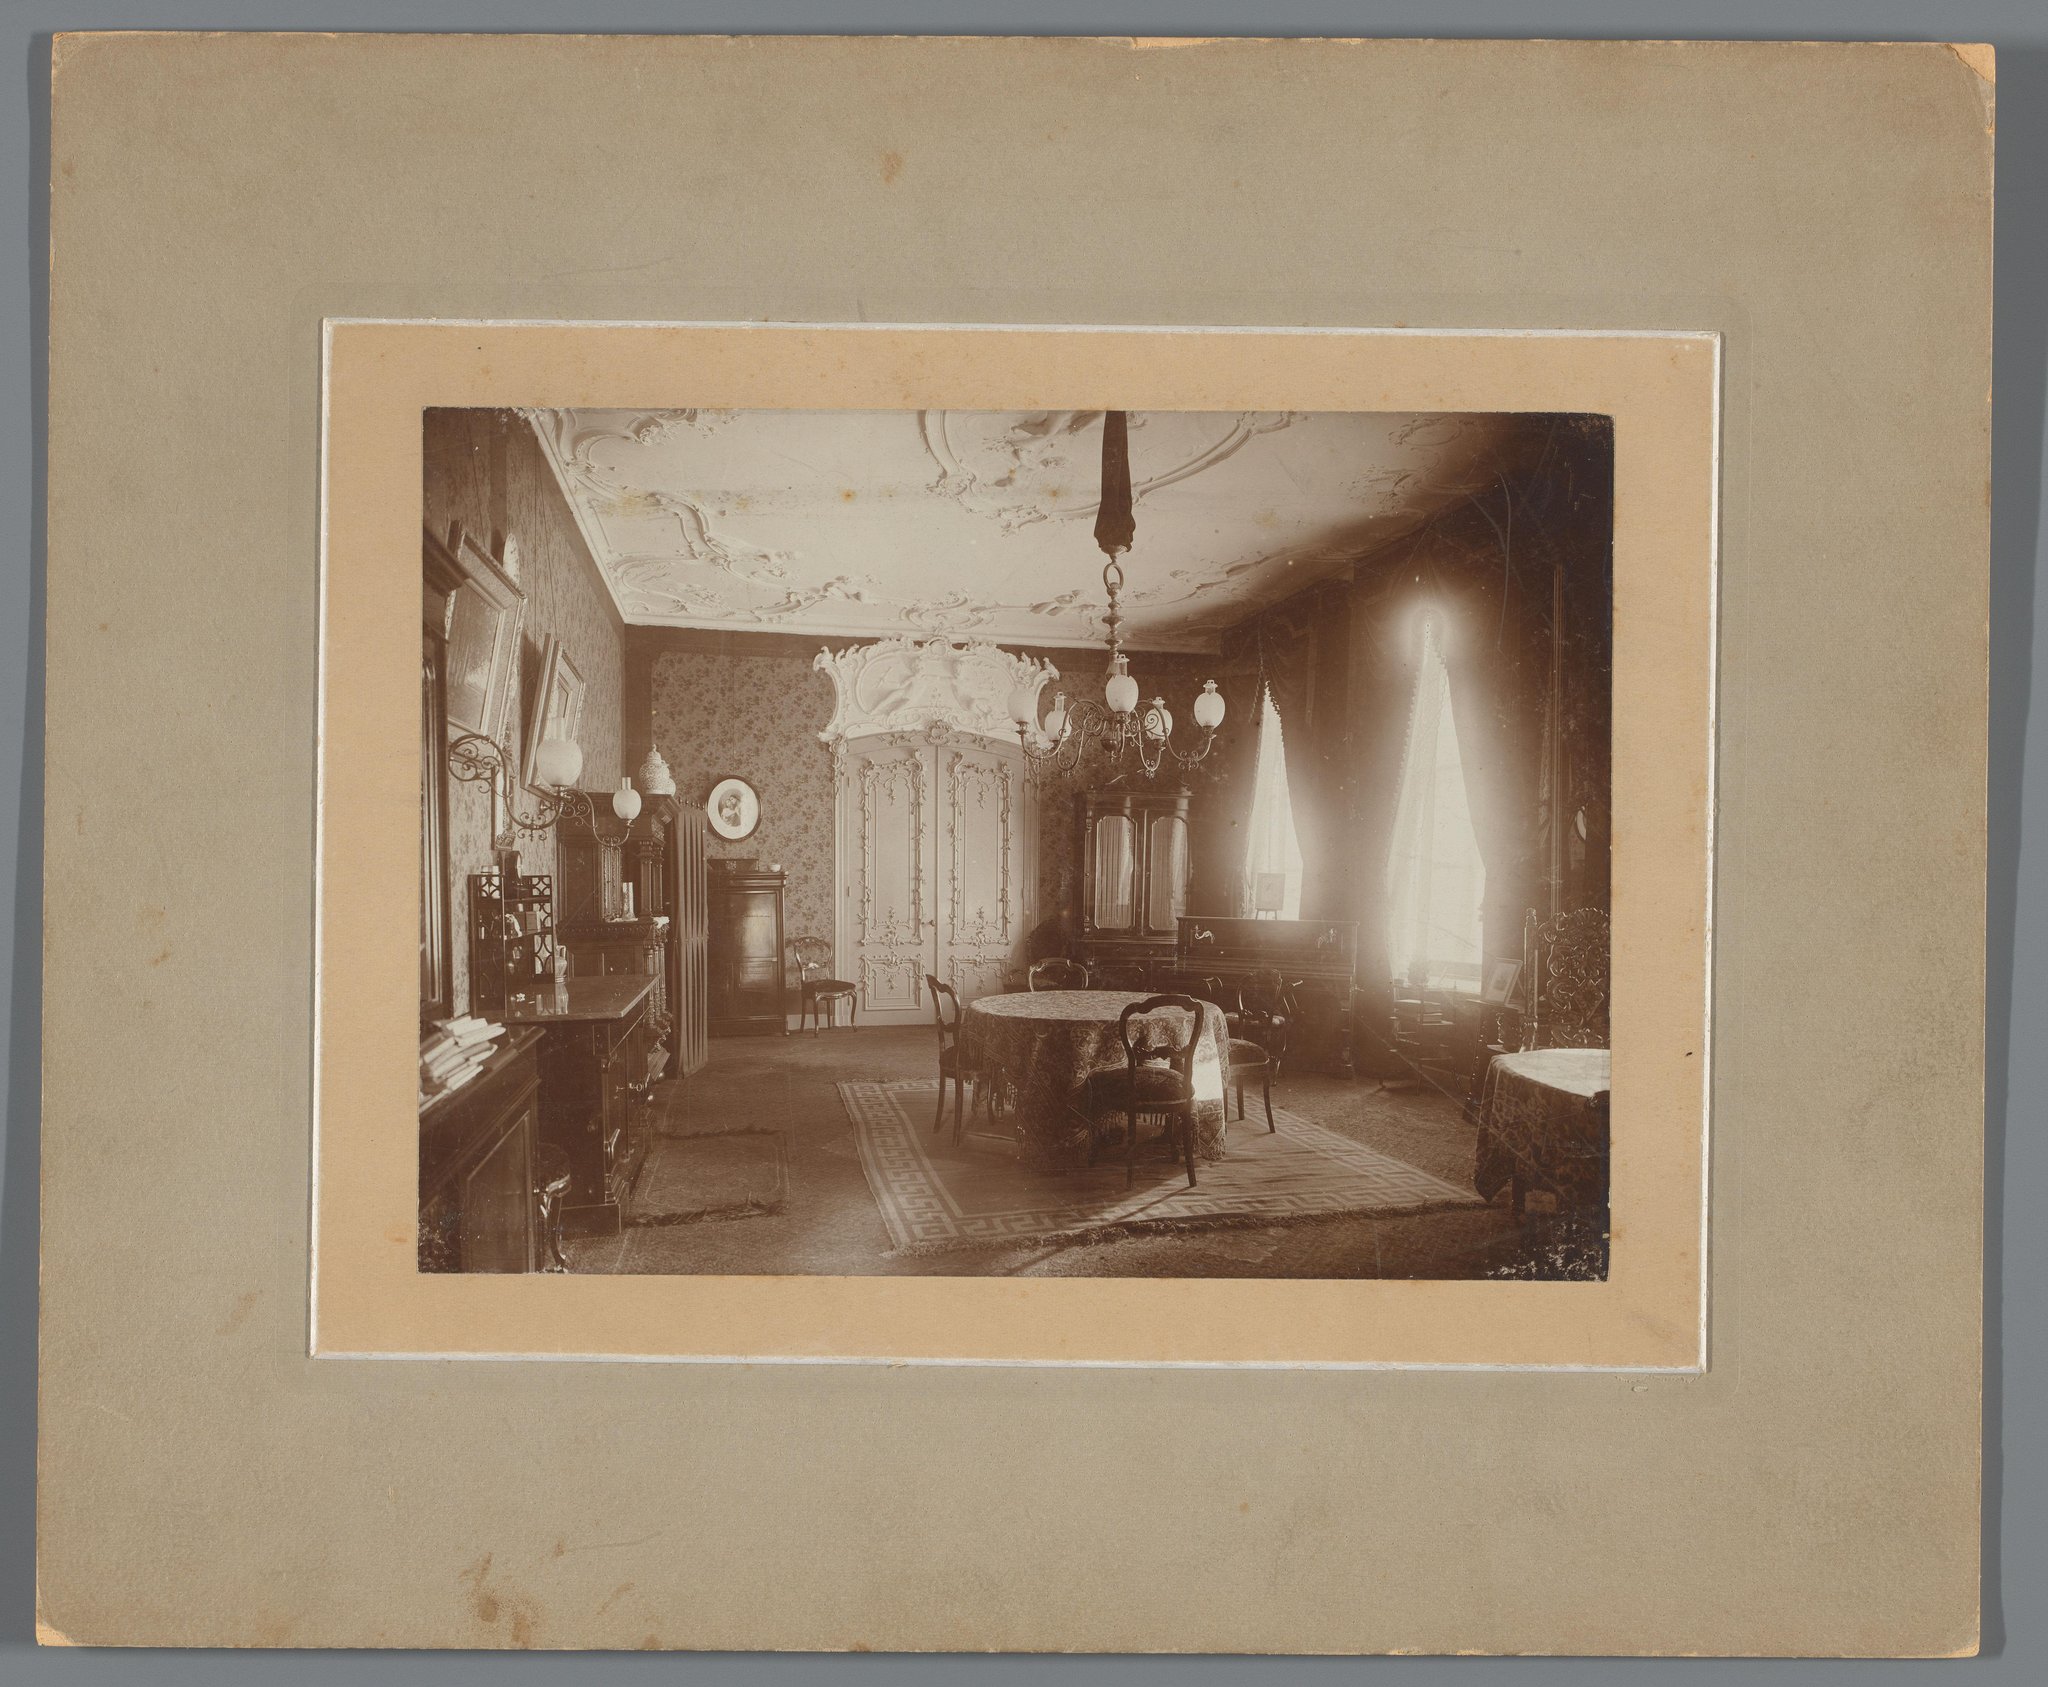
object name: photograph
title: Ambtswoning directeur postkantoor Deventer / directeur was NJAC Swellengrebel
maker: g.j. van den berg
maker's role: fotograaf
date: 1875-1899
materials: cardboard, photographic support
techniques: collodion silver print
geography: deventer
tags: post-office, villa - aa - civic architecture: inside, deventer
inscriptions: label: ‘D3’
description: De ambtswoning van de directeur van het postkantoor te Deventer, Nicolaas Jan Agatho Christiaan Swellengrebel.